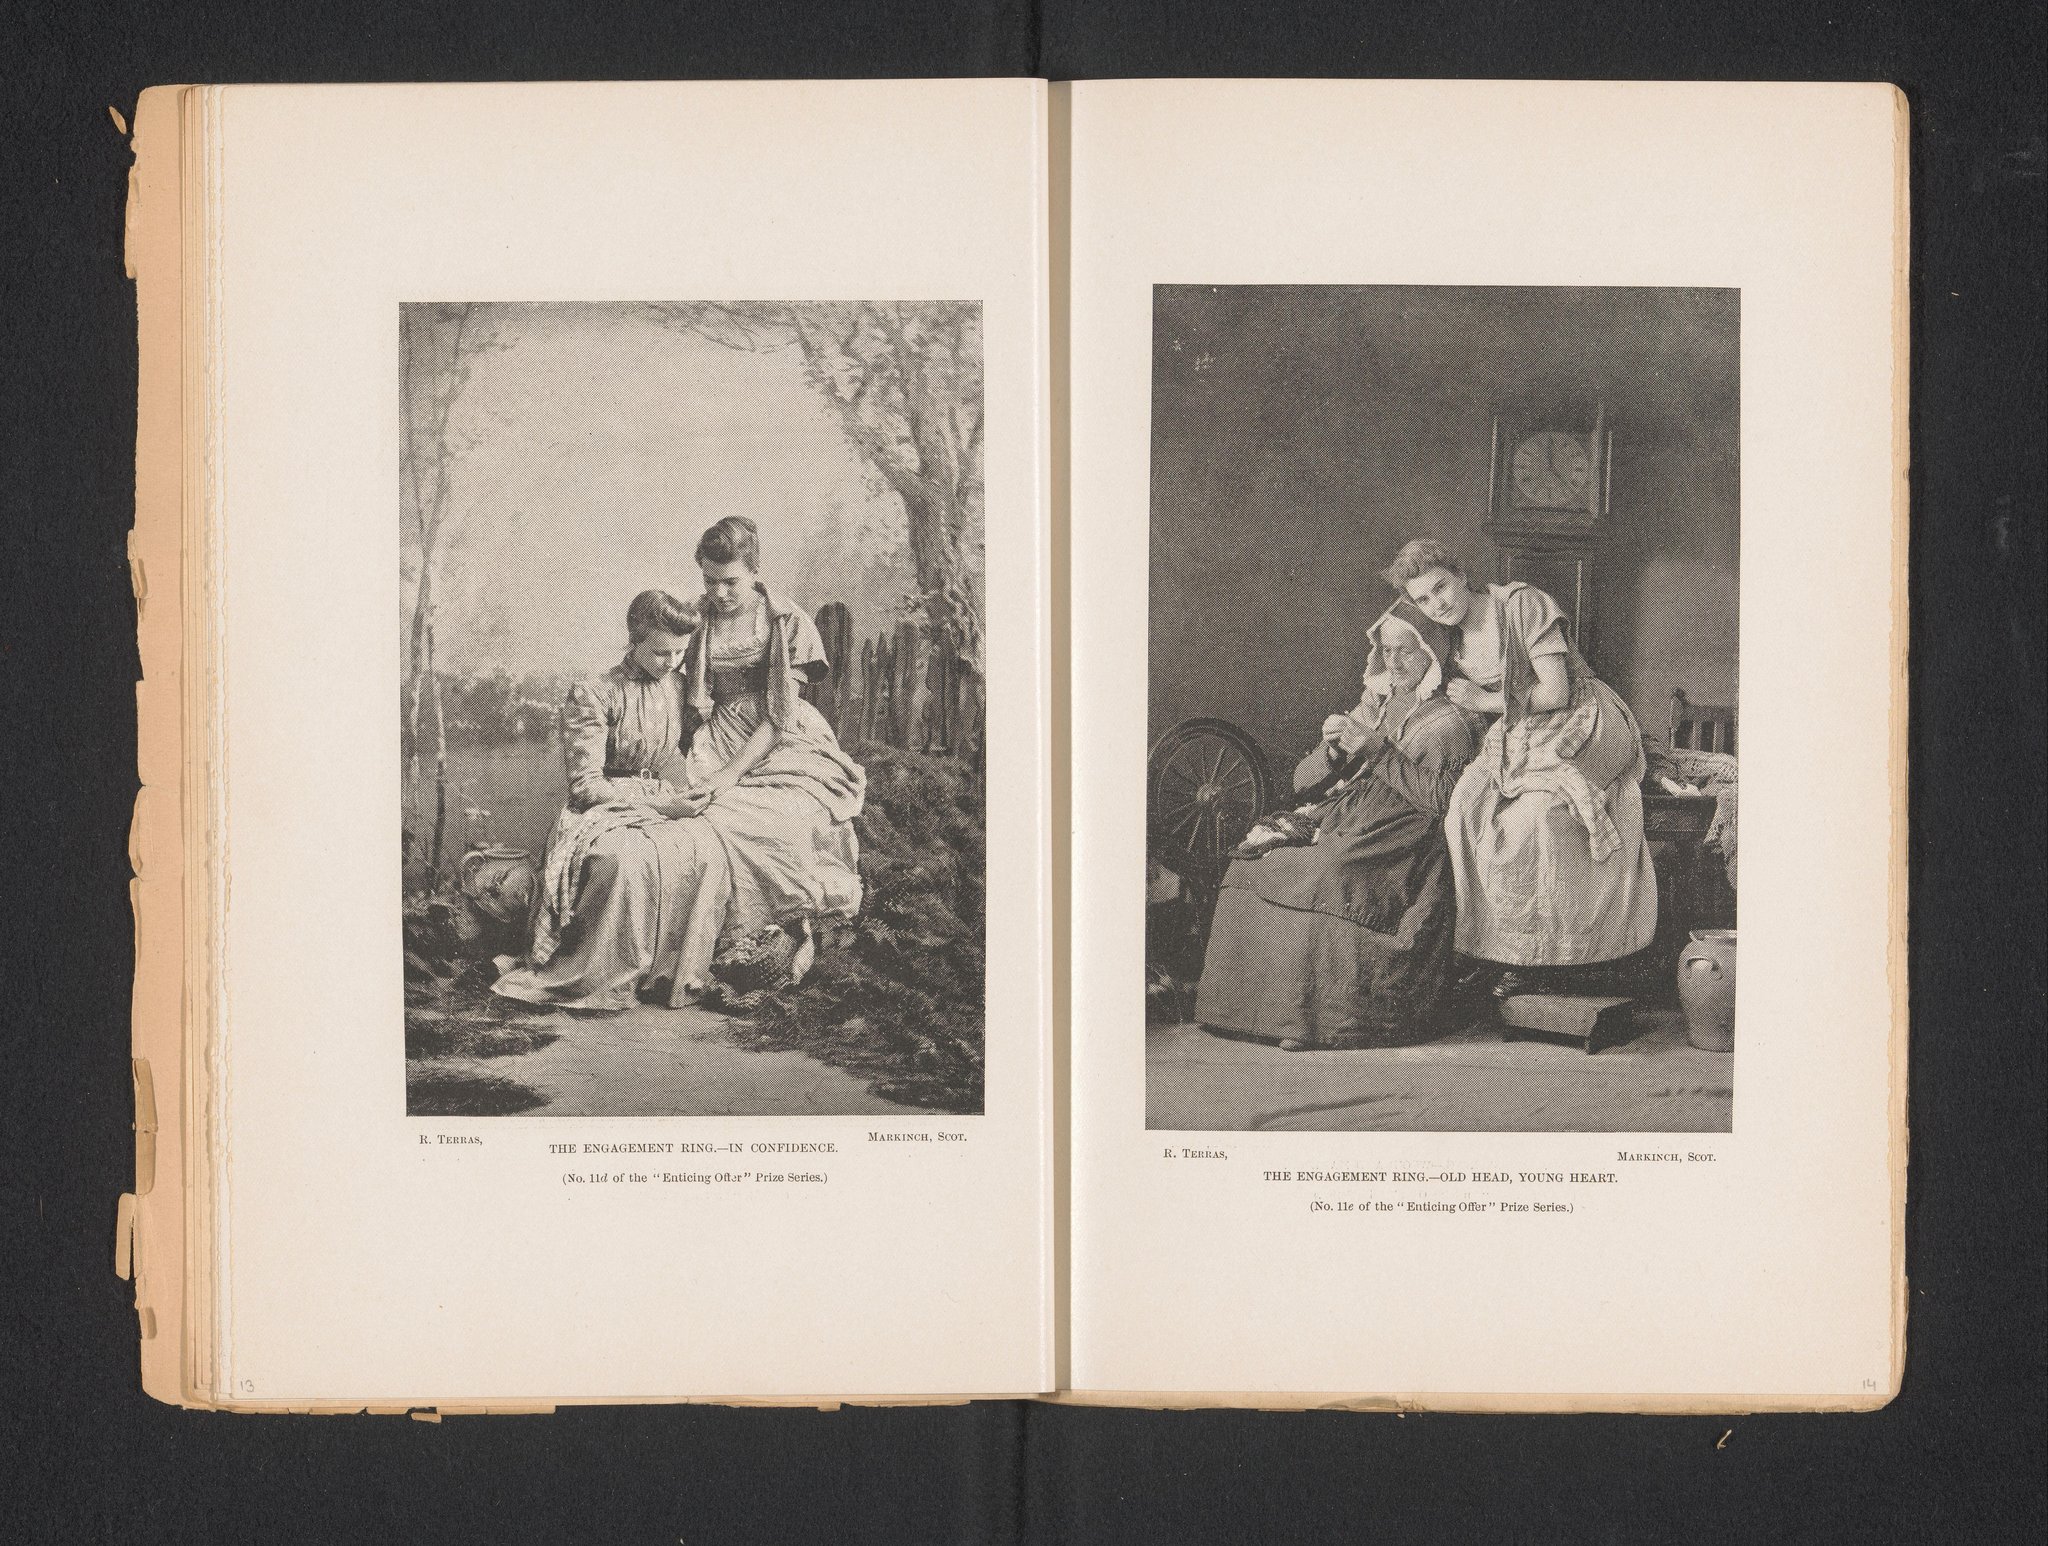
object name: page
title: The Engagement Ring. - In Confidence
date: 1887-1892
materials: paper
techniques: autotype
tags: historical persons not known by name - bb - woman, the consent (of marriage)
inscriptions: inscription: ‘(No. 11d of the "Enticing Offer" Prize Series.)’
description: Prent dertien van vijftien prenten tussen pagina viii en pagina 545.